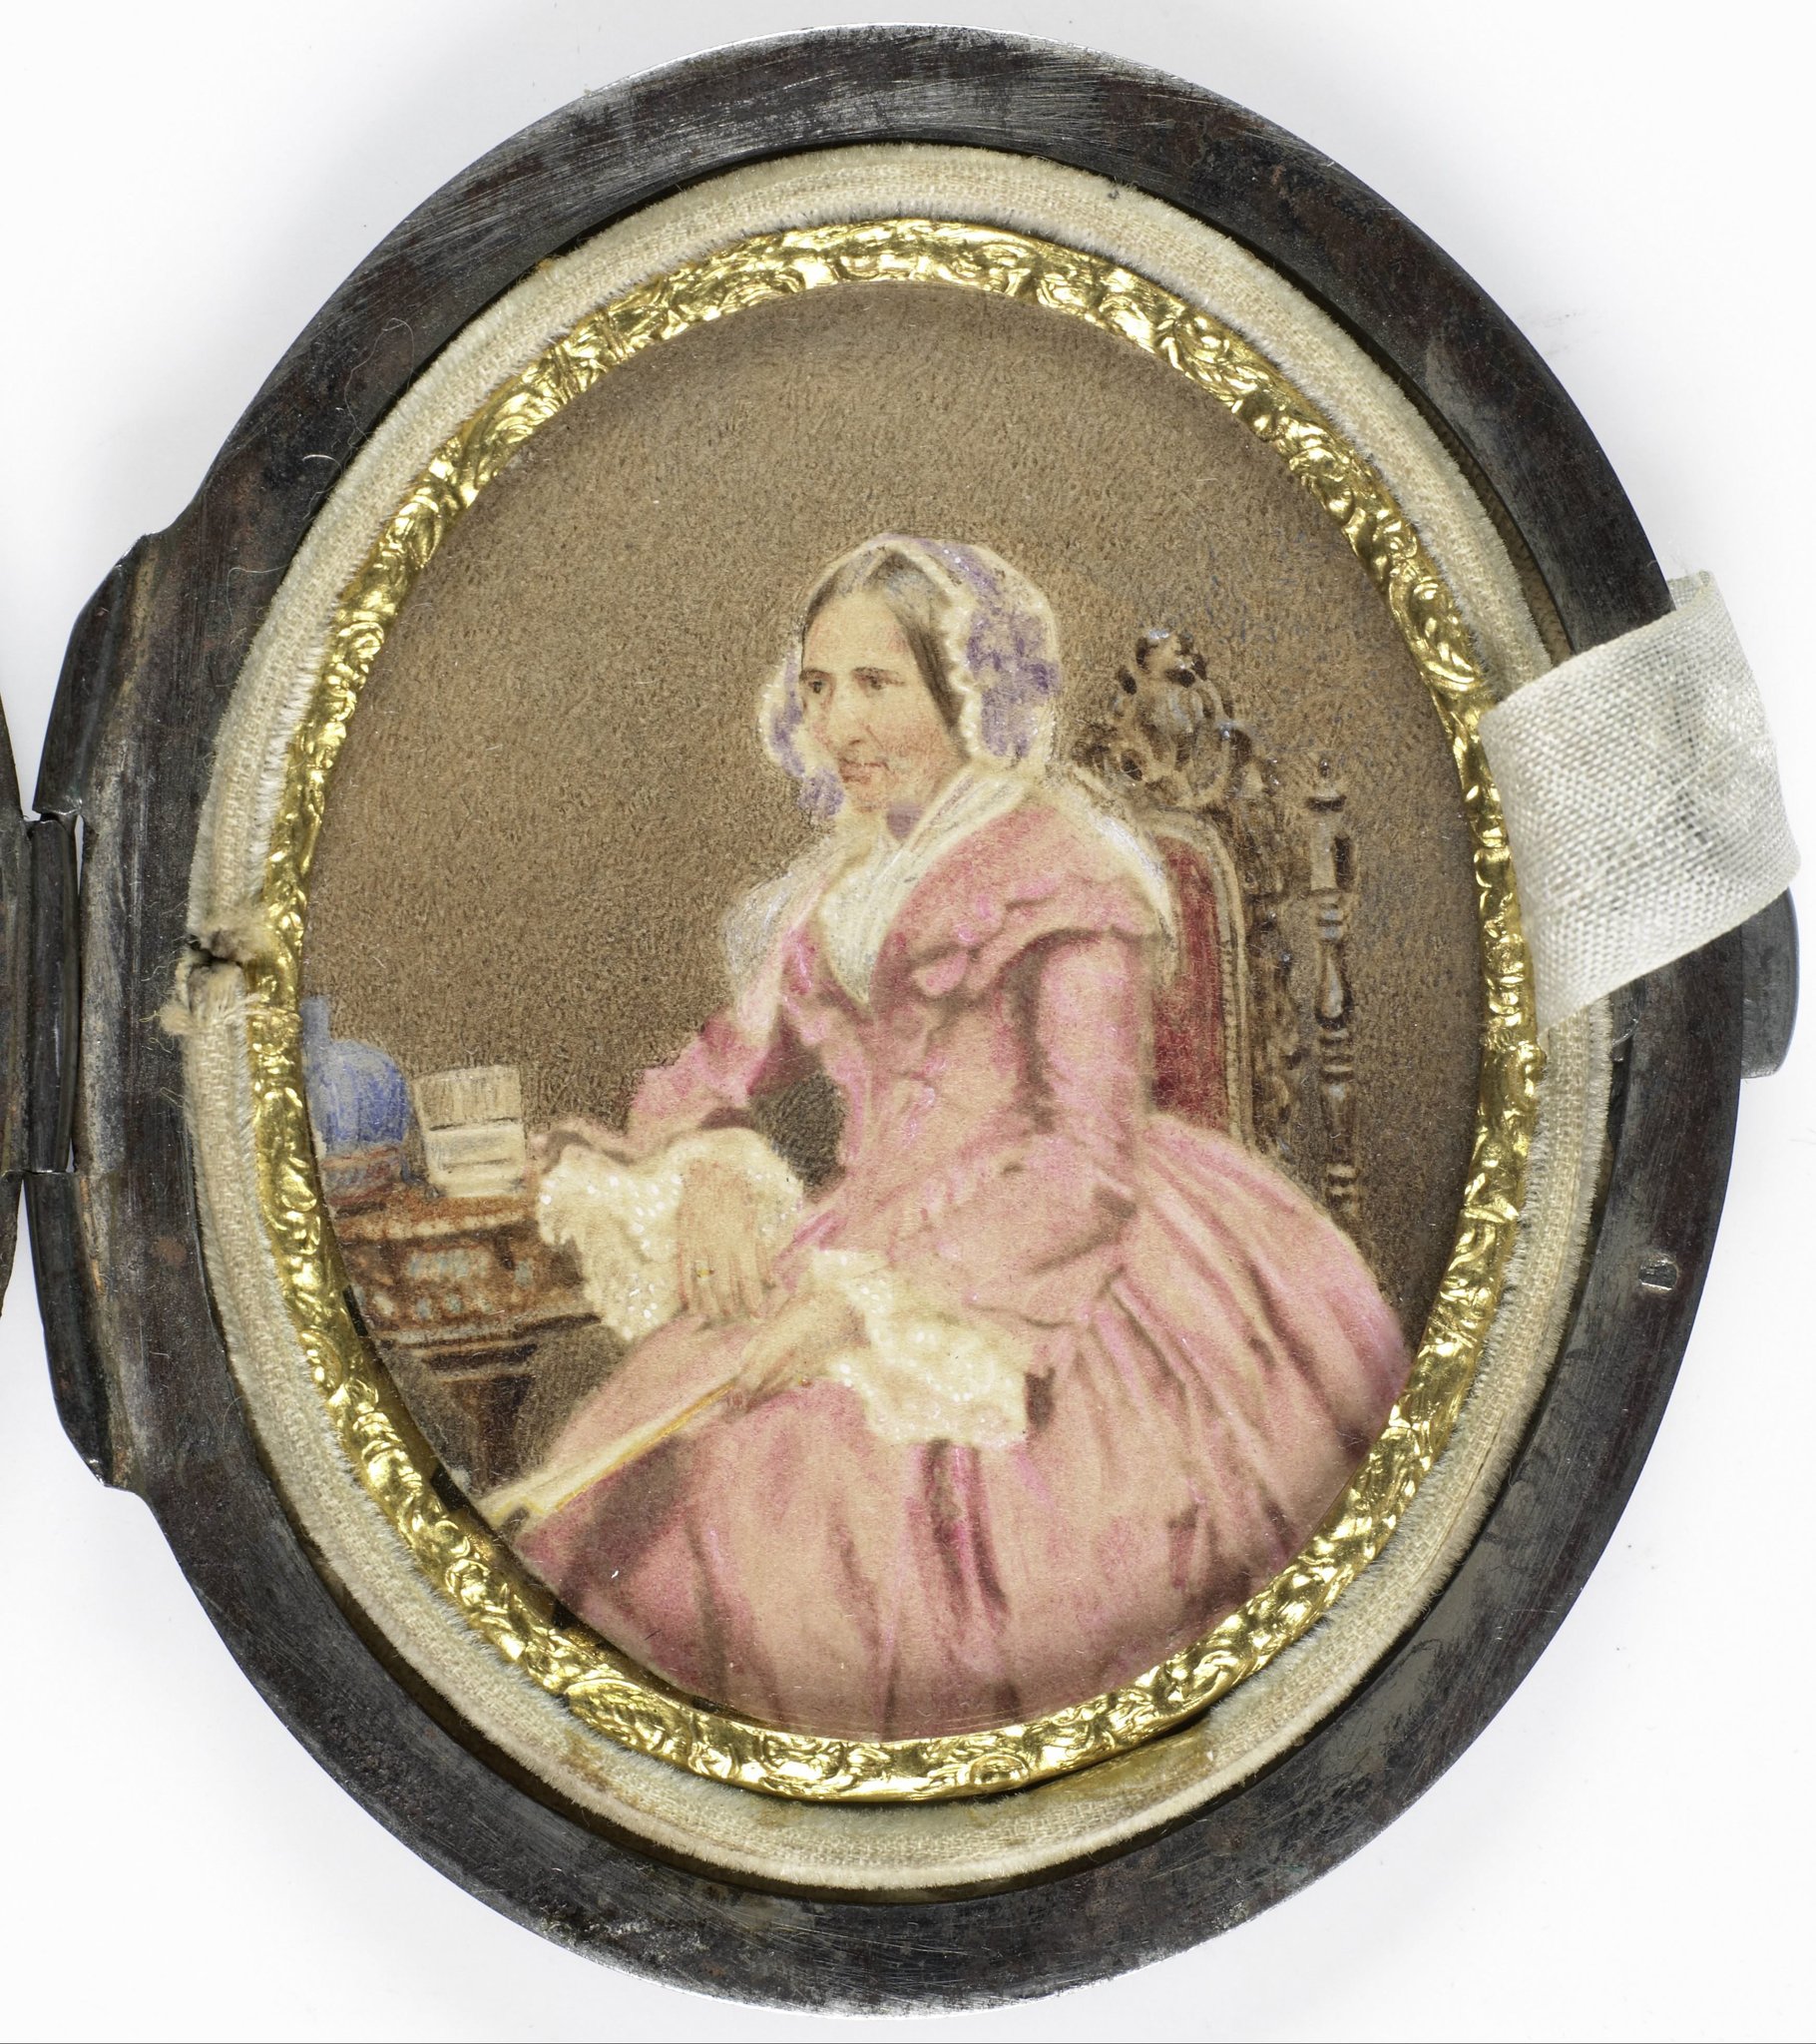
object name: locket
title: Portret van een onbekende vrouw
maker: Anonymous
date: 1840-1860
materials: glass, leather, metal, paper, textile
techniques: salted paper print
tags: historical persons not known by name - bb - woman